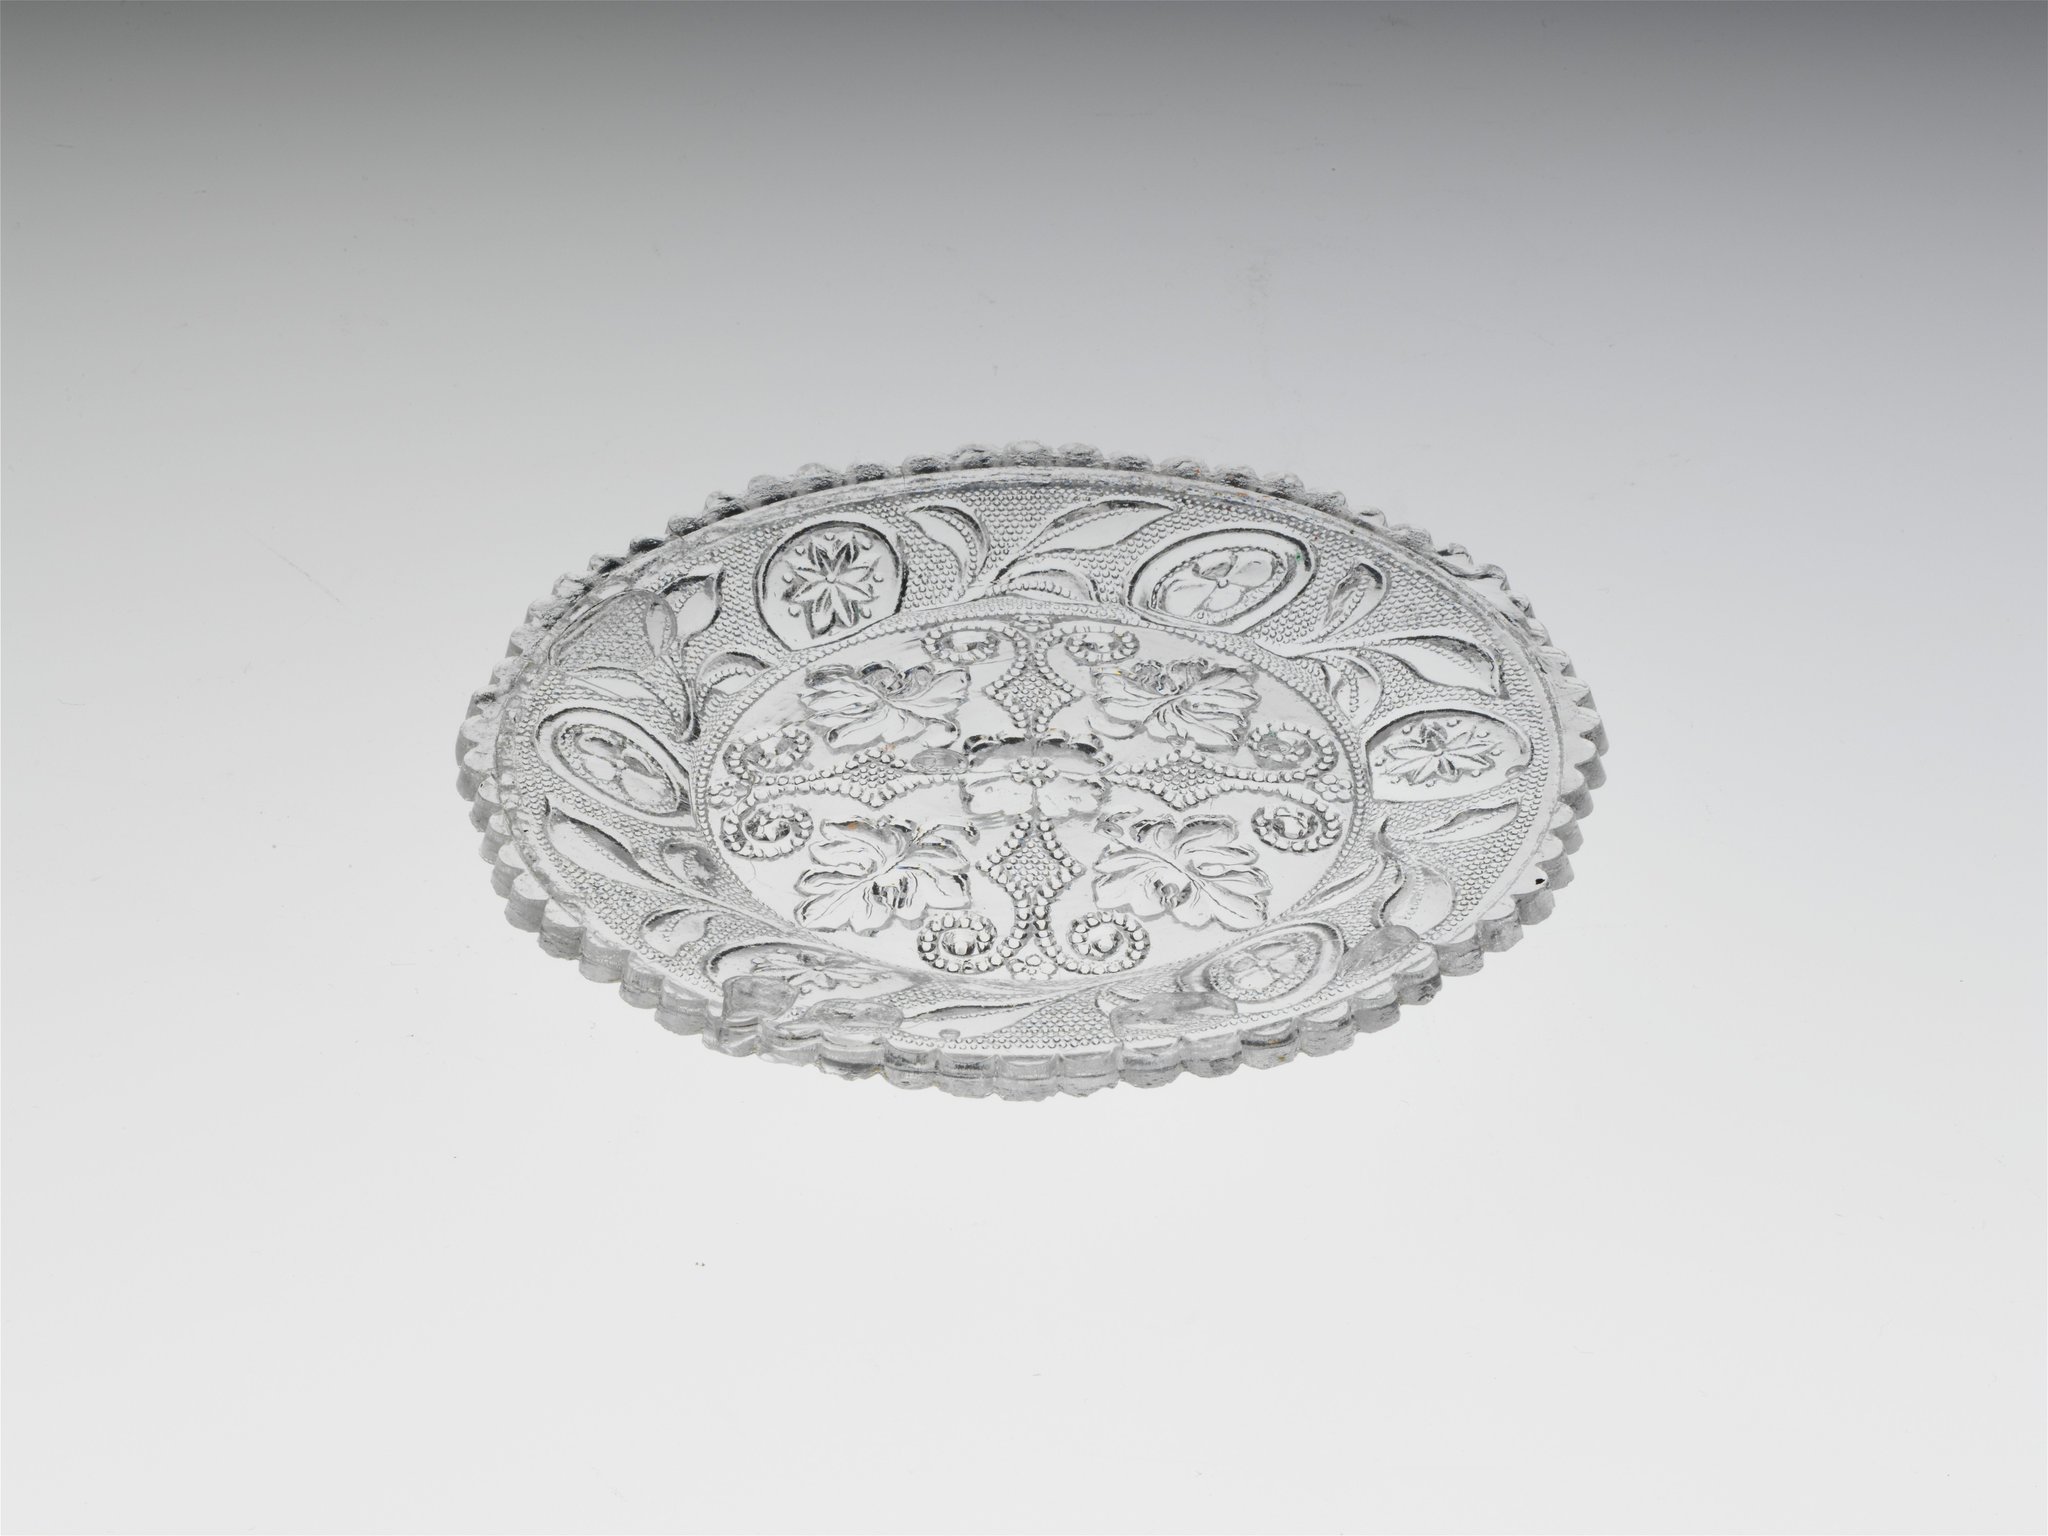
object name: cup plate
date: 1825-1860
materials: glass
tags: flowers